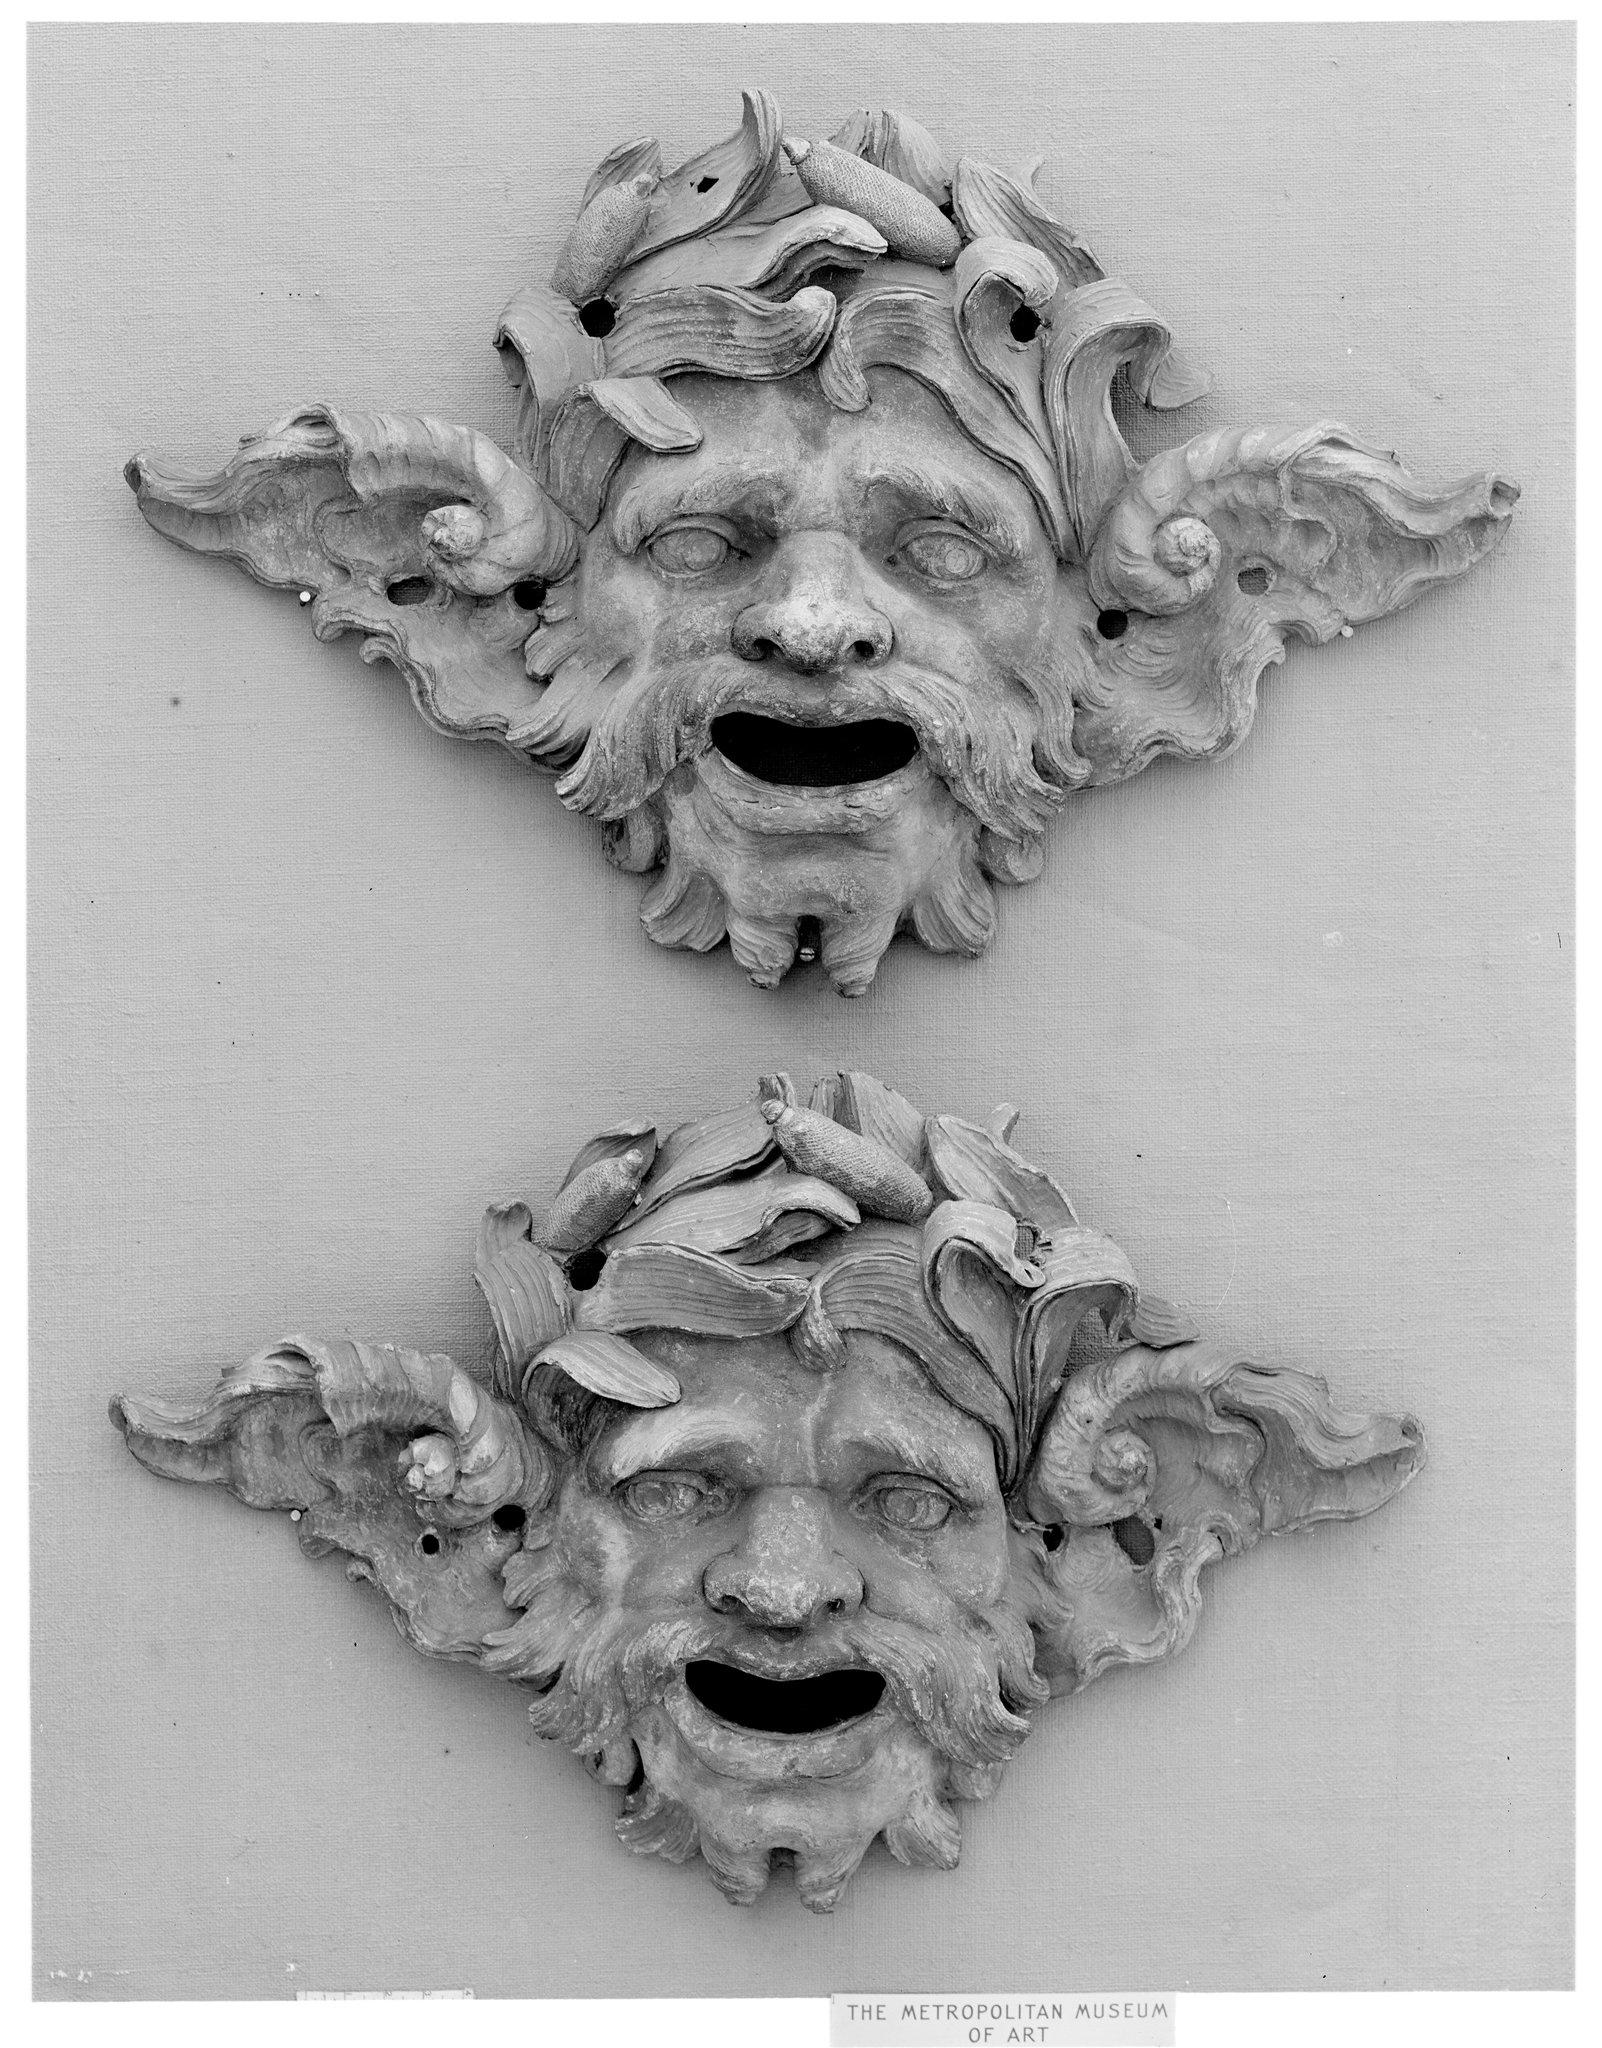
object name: mask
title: Mask (one of a pair)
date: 1701-1800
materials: lead